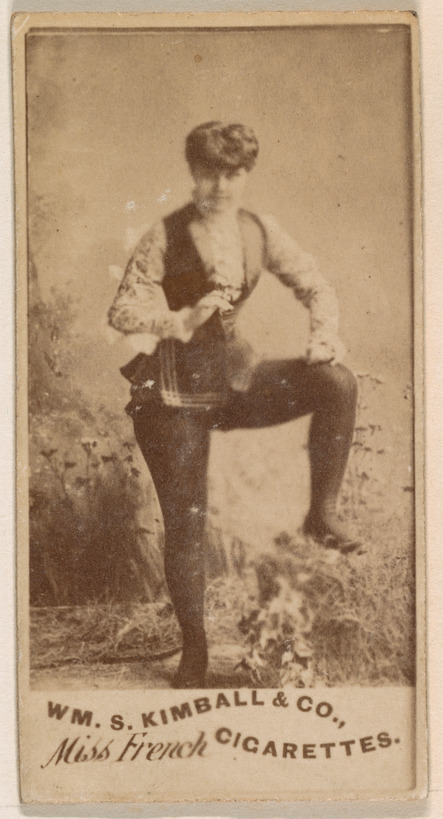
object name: photograph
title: Miss French, from the Actresses series (N203) issued by Wm. S. Kimball & Co.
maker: william s. kimball & company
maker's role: publisher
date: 1889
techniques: color lithograph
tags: portraits,women,actresses